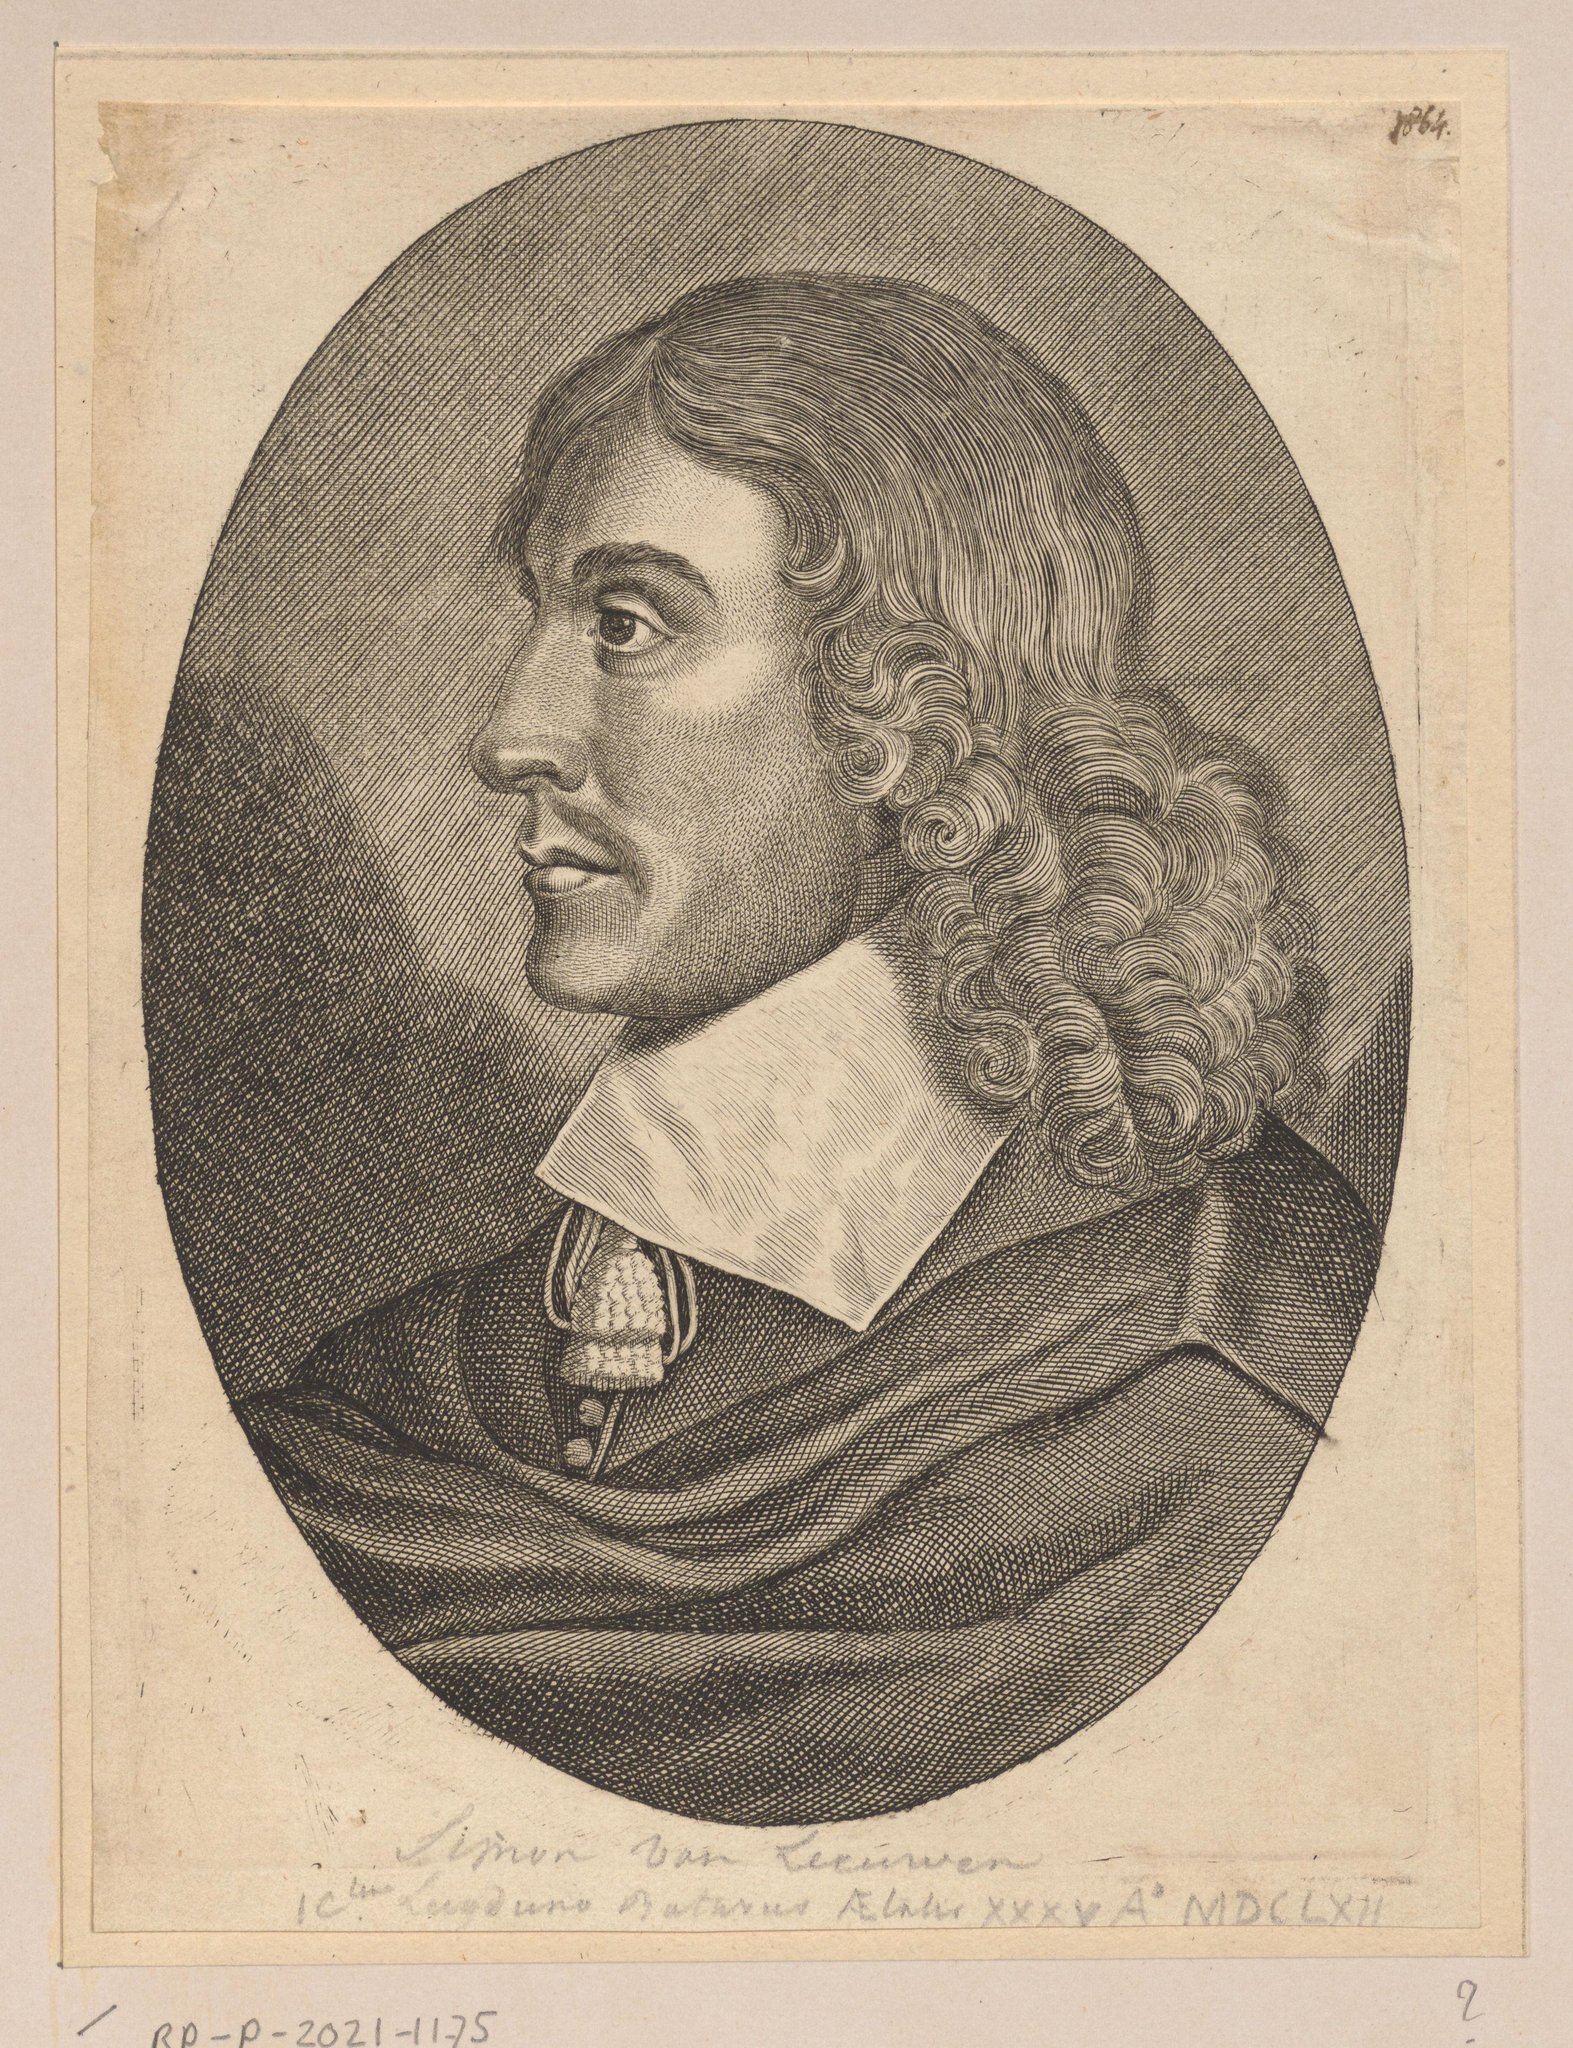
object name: print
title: Portret van Simon van Leeuwen op 35-jarige leeftijd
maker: Anonymous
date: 1662-1712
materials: paper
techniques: engraving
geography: northern netherlands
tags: leiden, the hague, simon van leeuwen, ornament ~ medallion, historical persons, lawyer, attorney at law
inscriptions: inscription: ‘Simon van Leeuwen/ Ic.tus Lugduno Batavus/ Aetatis XXXV Ao. MDCLXII’, number: ‘1864’